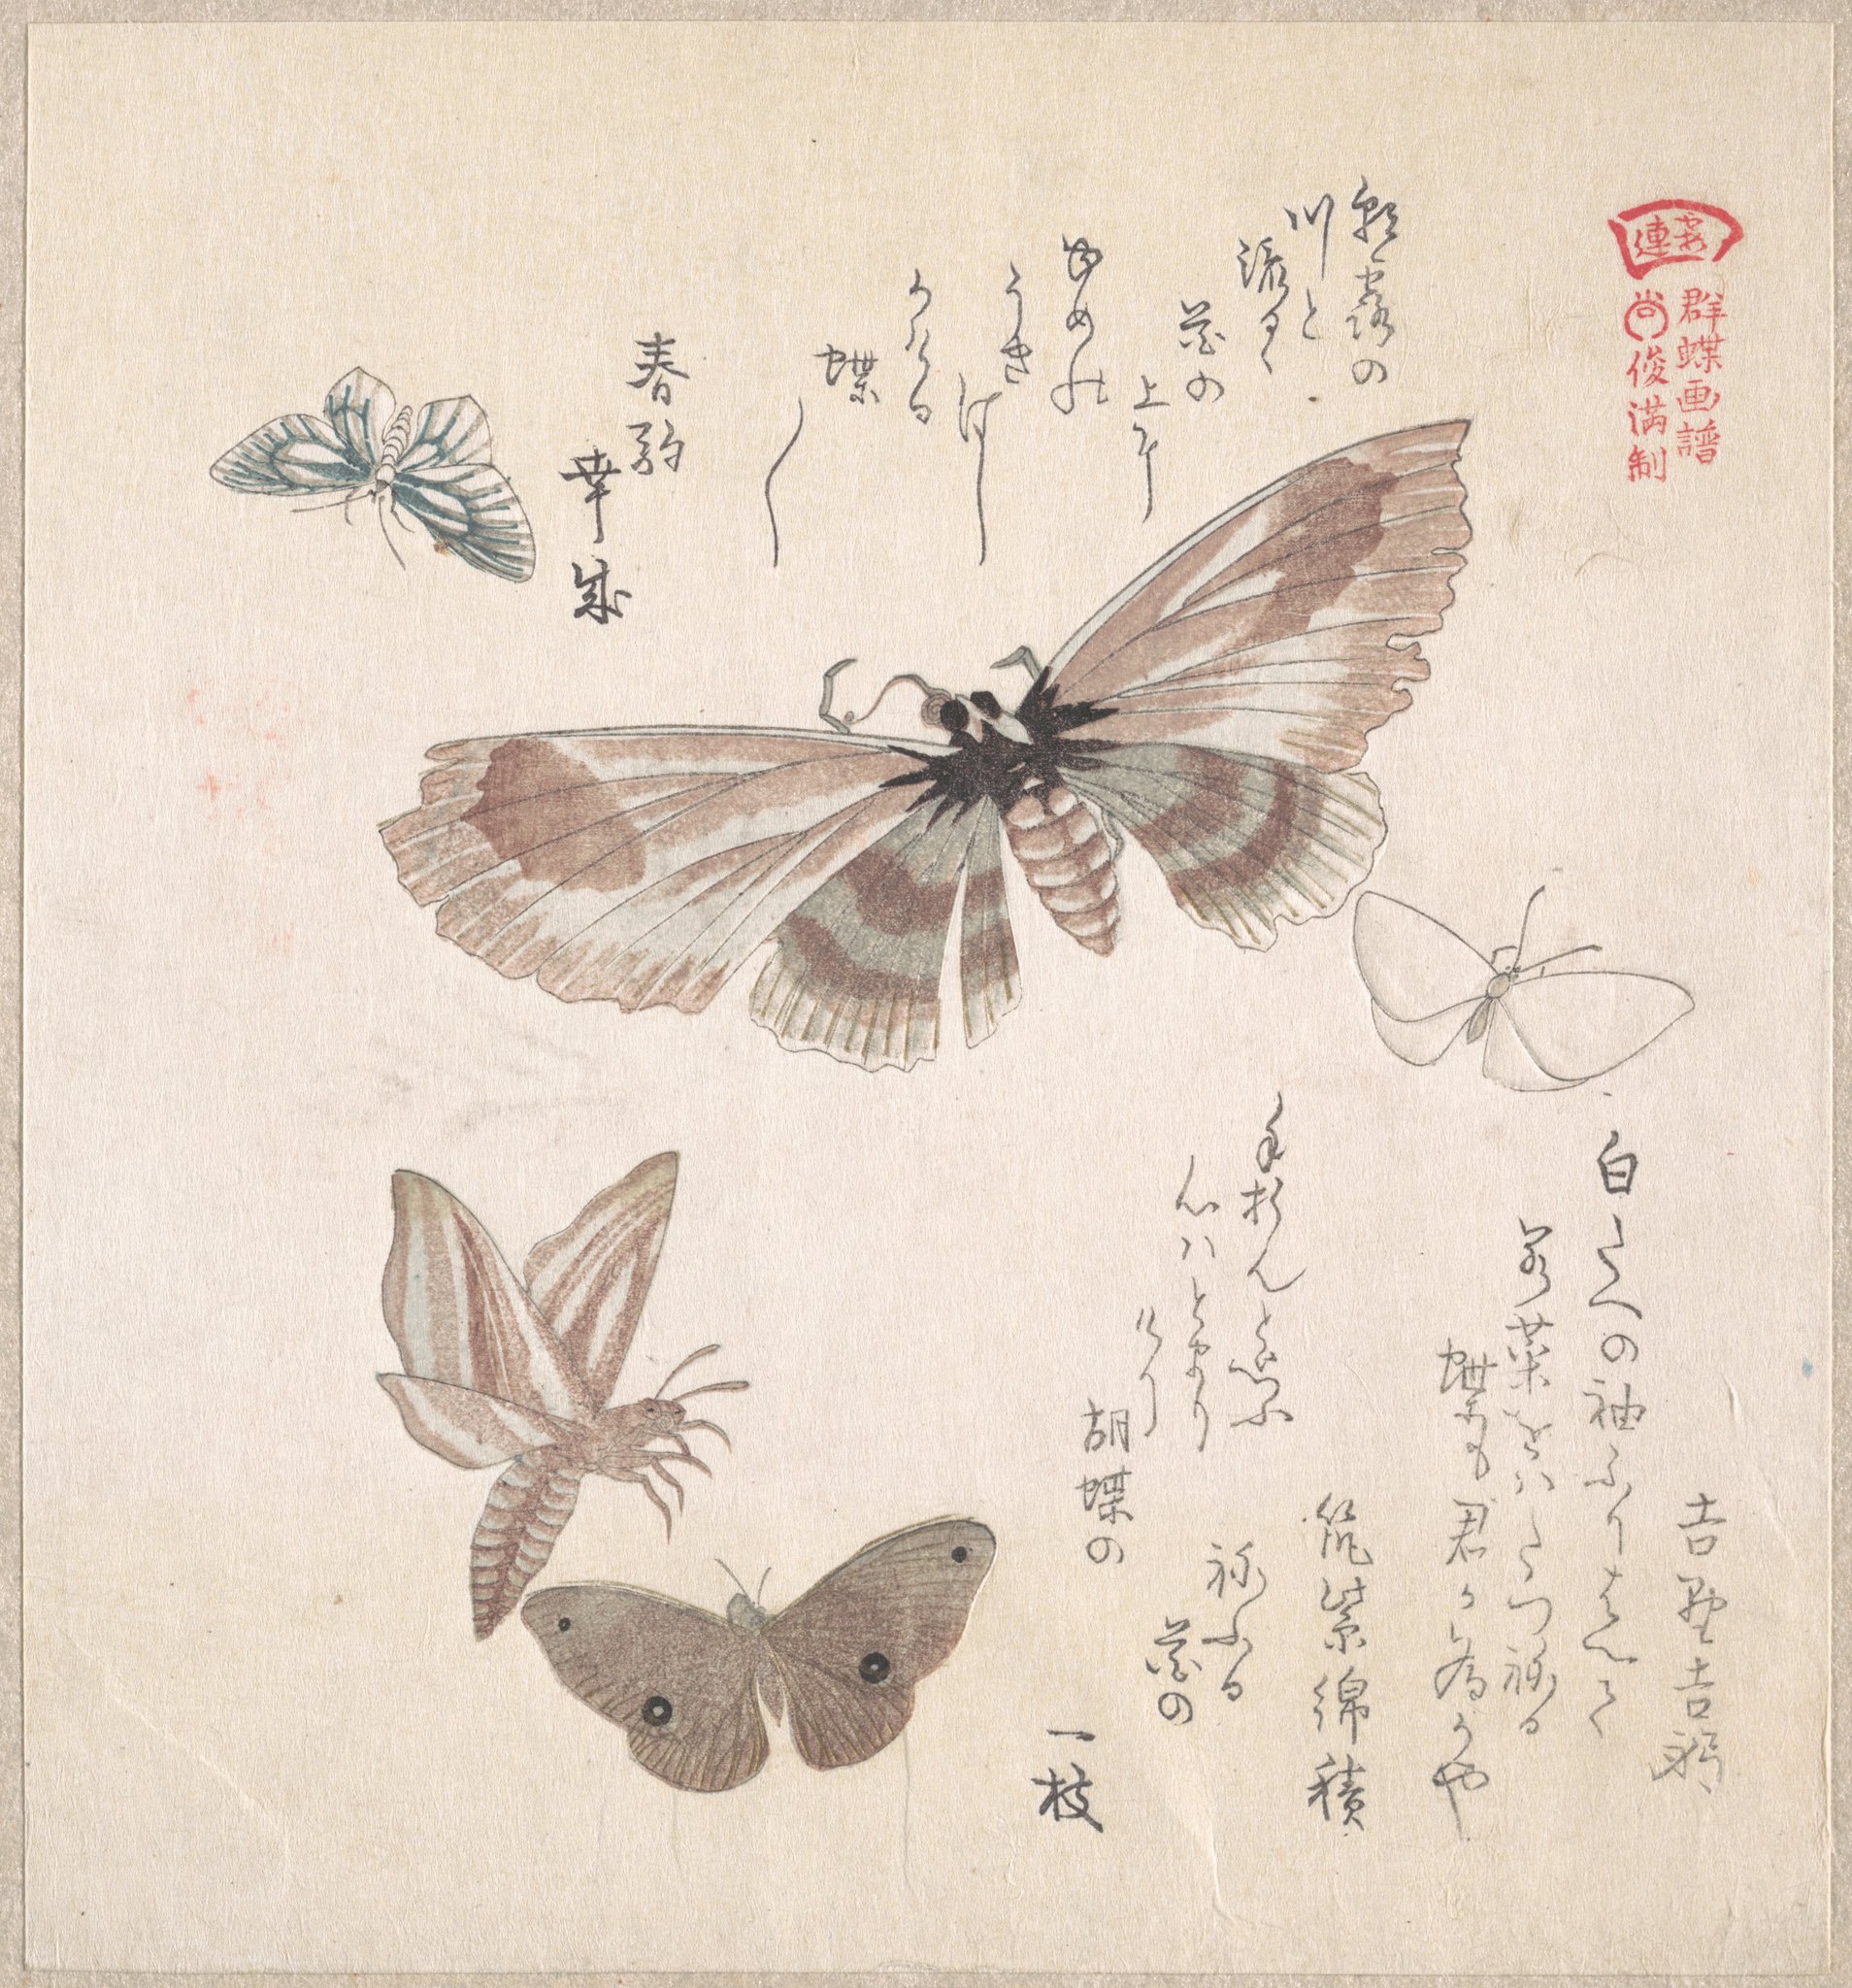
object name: print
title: Various Moths and Butterflies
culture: japanese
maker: kubo shunman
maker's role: artist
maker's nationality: japanese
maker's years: 1757-1820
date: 1801-1900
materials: ink, paper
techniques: surimono, woodblock print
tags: butterflies